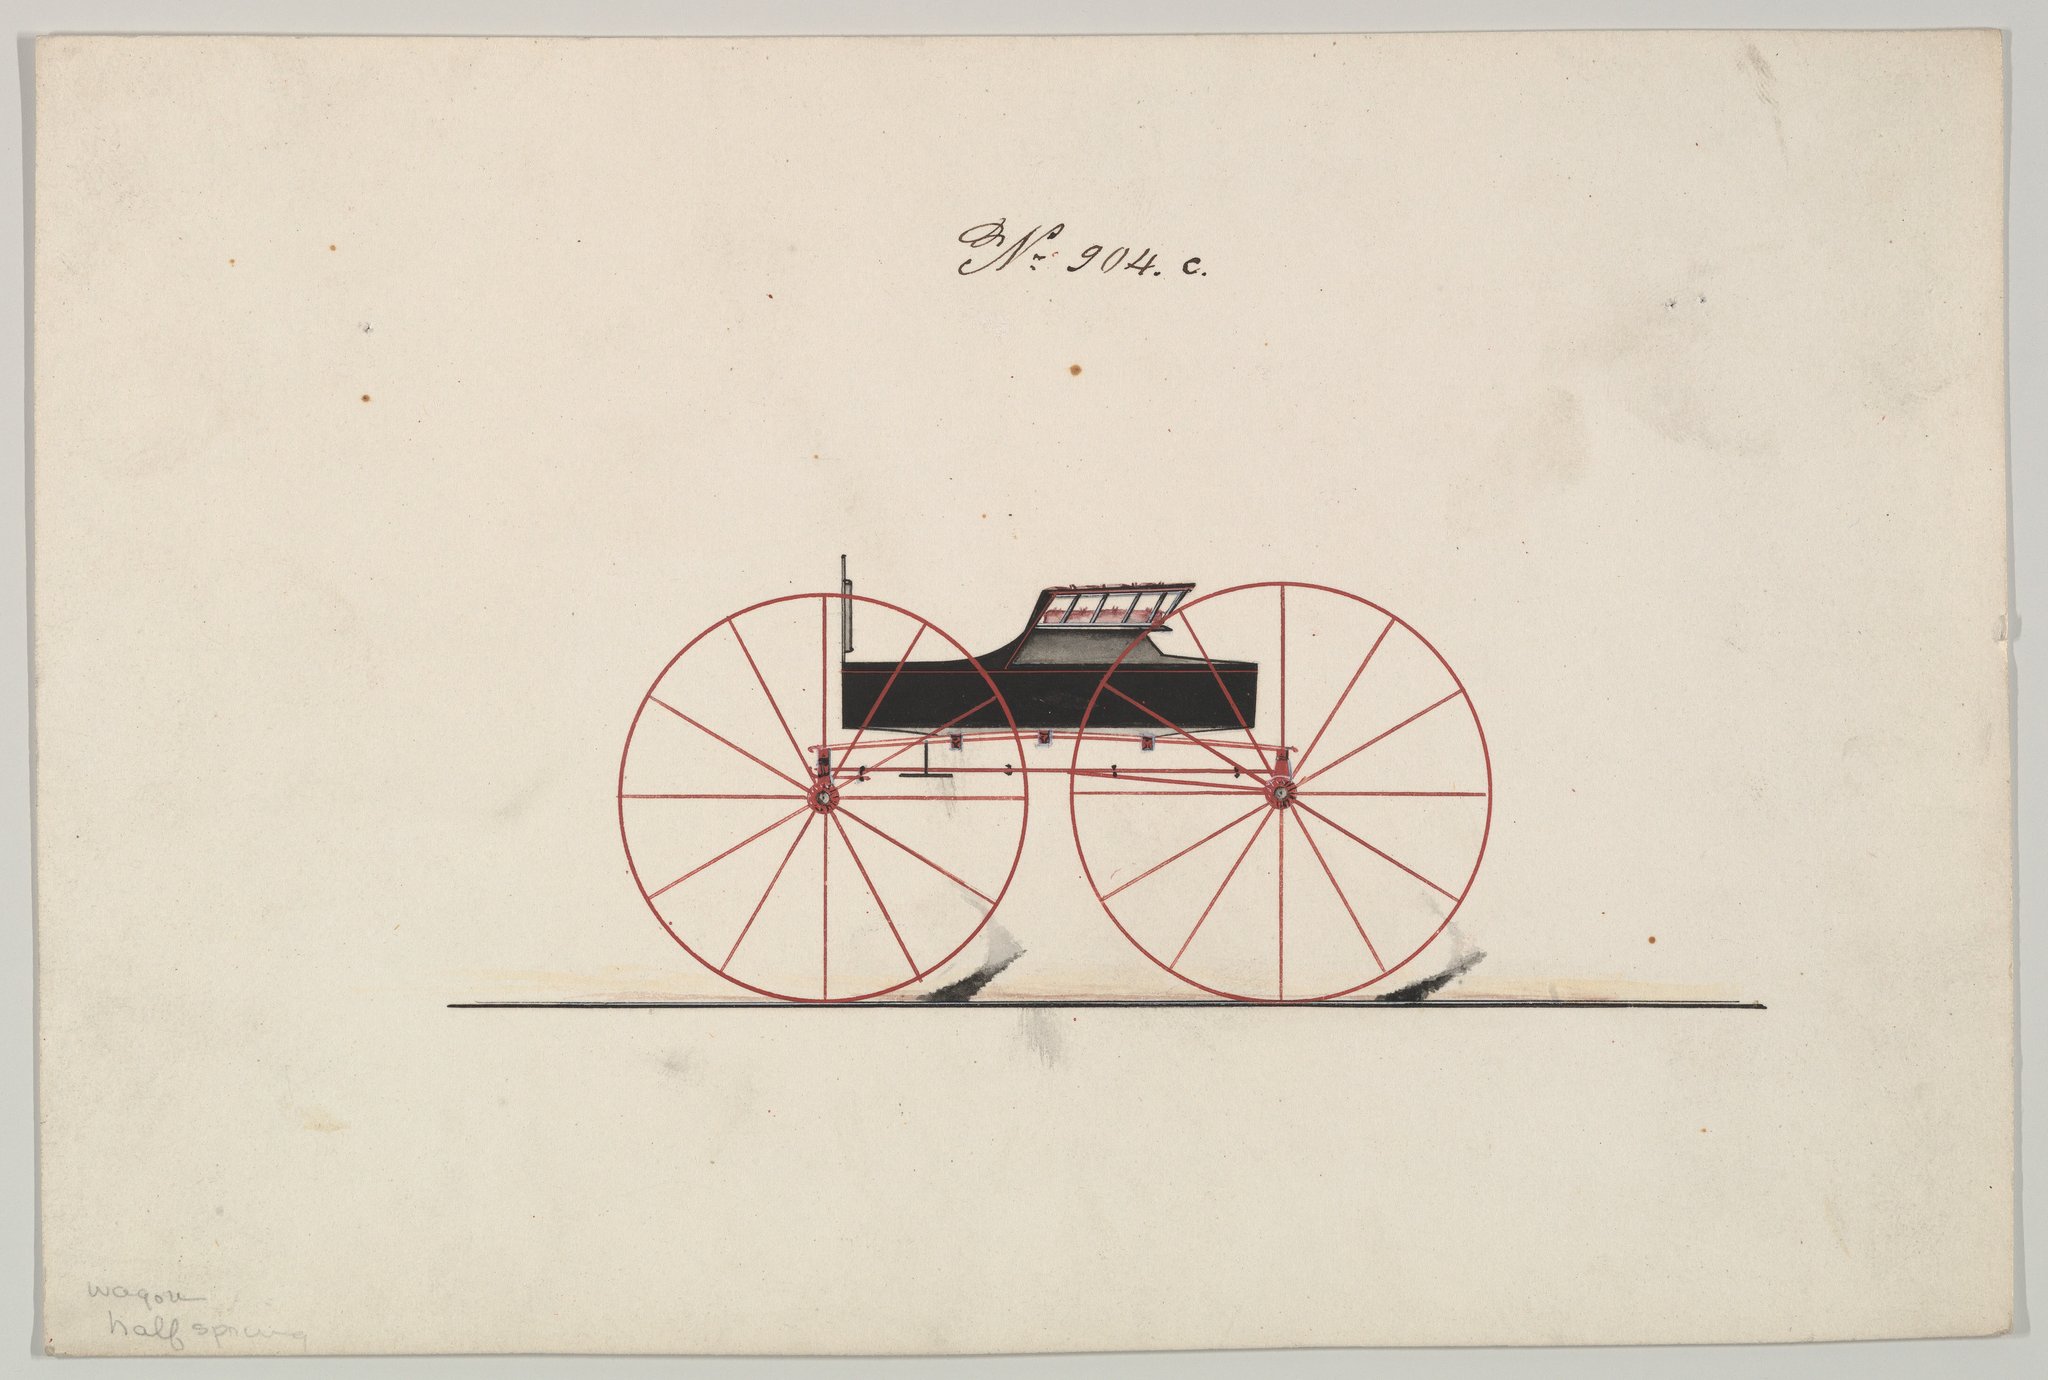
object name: drawing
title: Design for Wagon, no. 904c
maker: brewster & co.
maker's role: manufacturer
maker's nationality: american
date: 1860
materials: gouache, ink, watercolor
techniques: pen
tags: carriages